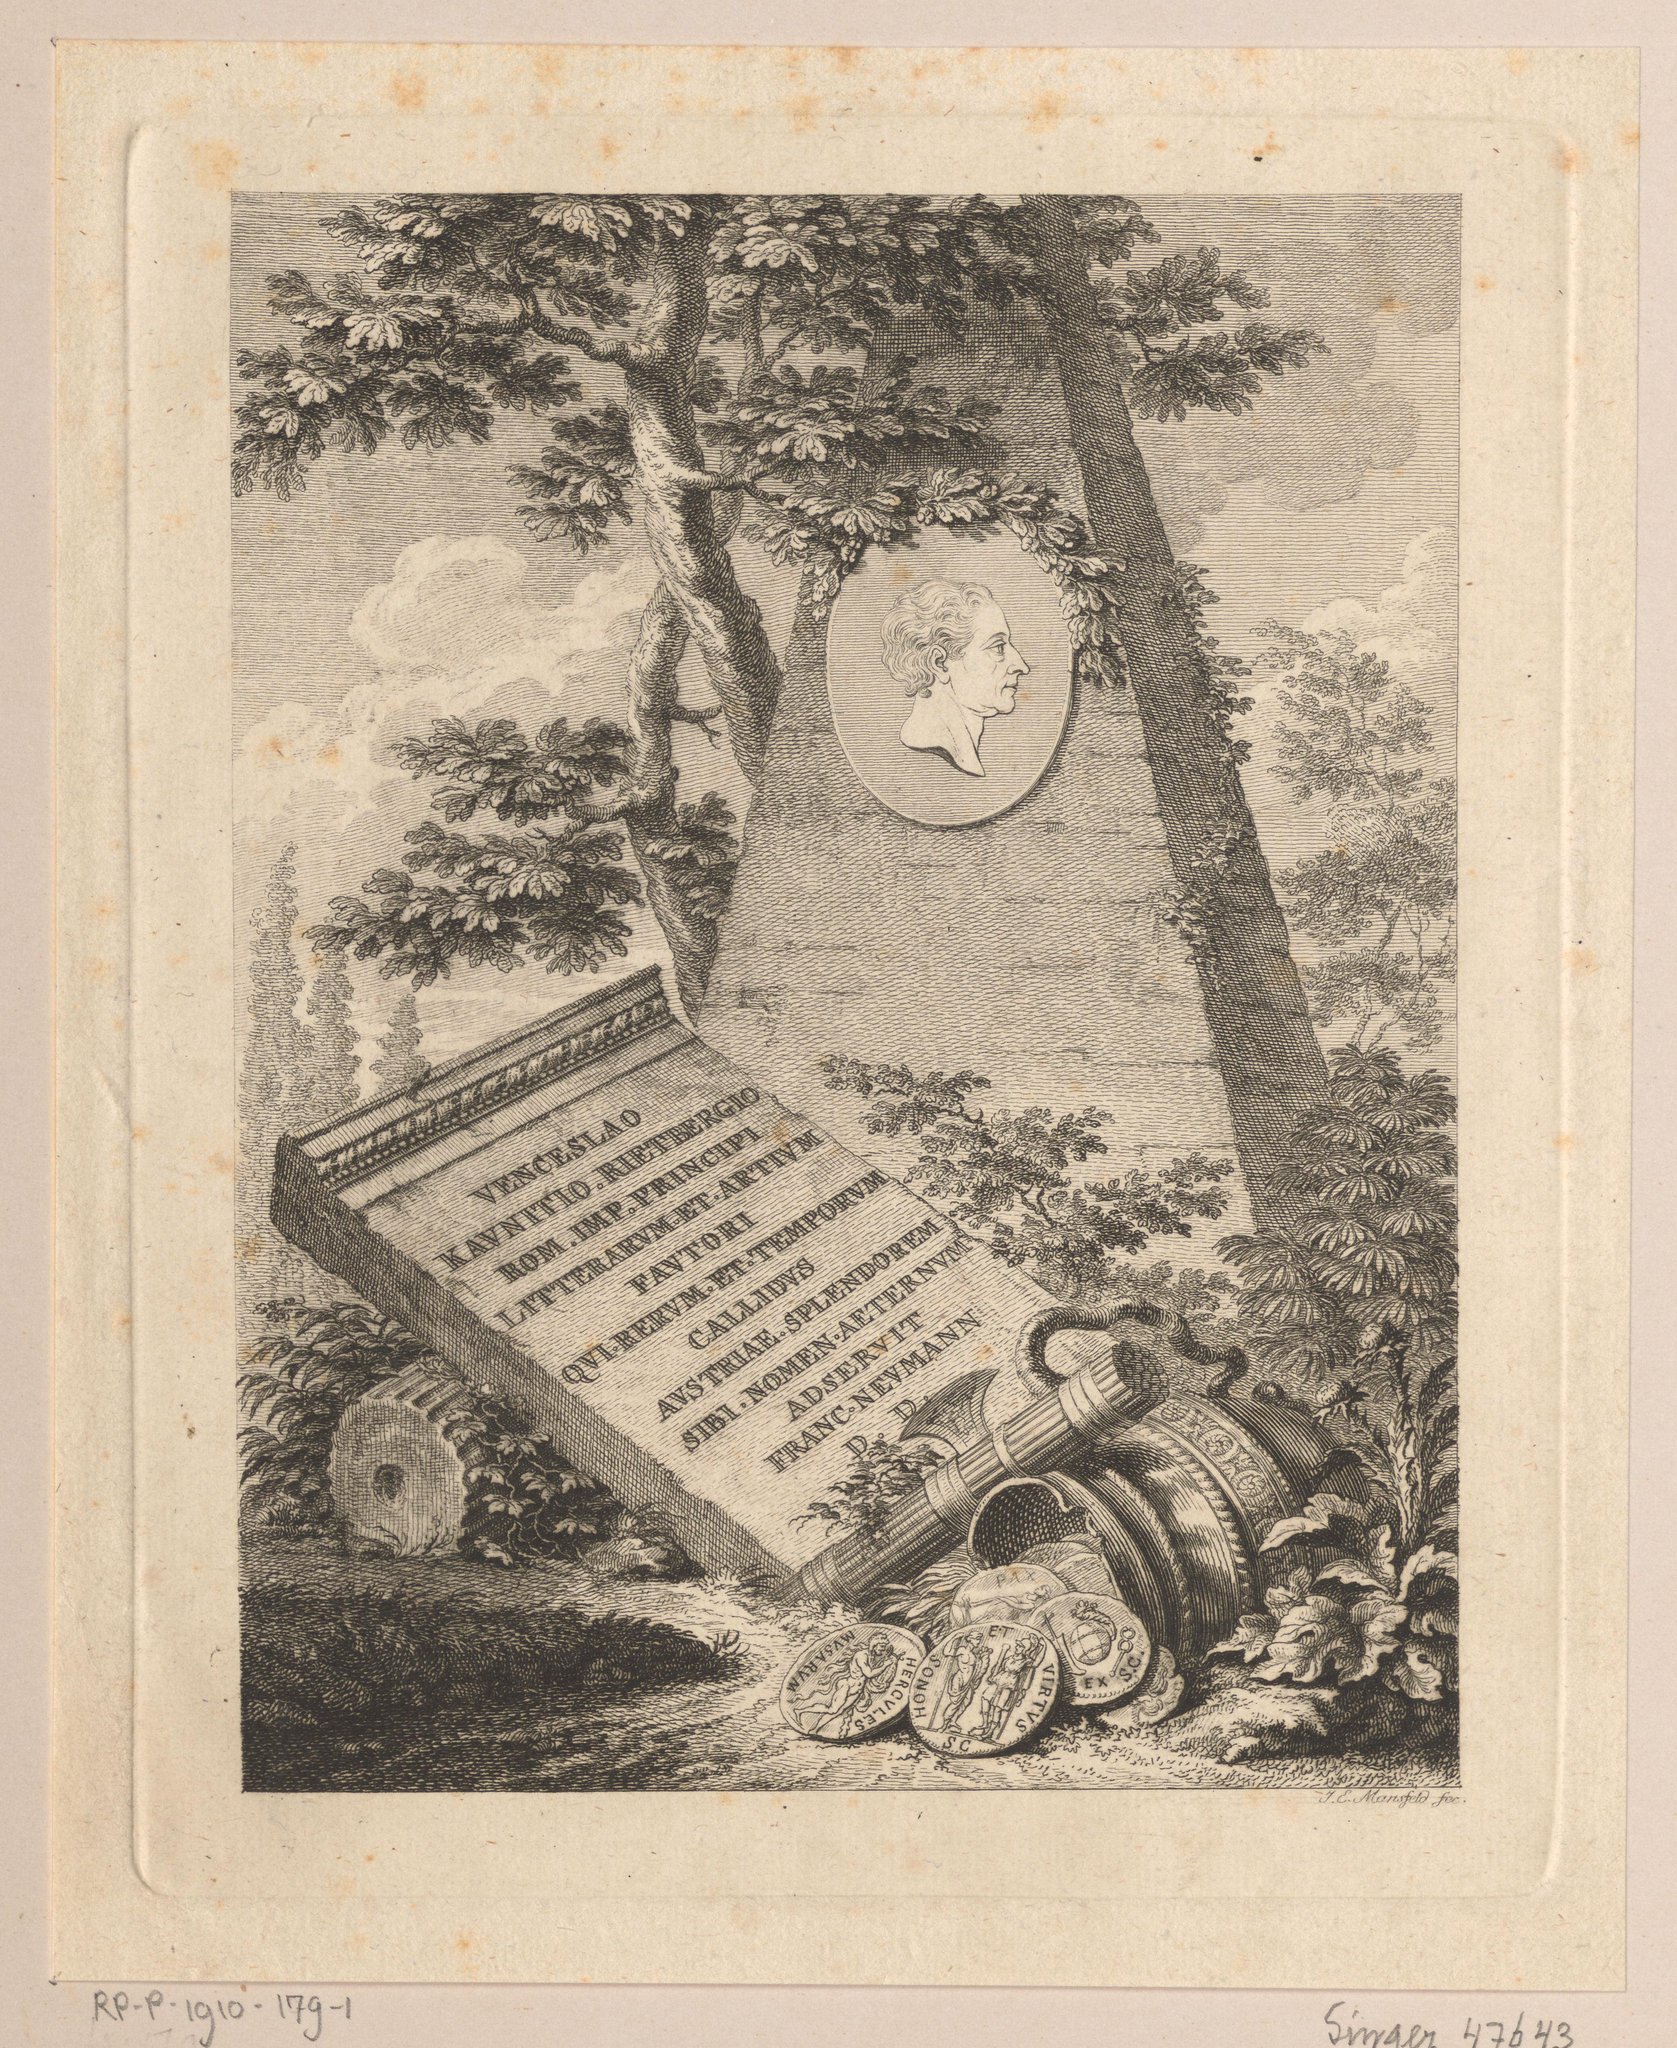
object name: print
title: Gedenknaald van Wenzel Anton von Kaunitz-Rietberg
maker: johann ernst mansfeld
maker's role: print maker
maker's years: 1739-1796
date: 1749-1796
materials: paper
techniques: engraving, etching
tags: obelisk, needle, historical persons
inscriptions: collector's mark: Lugt 2228